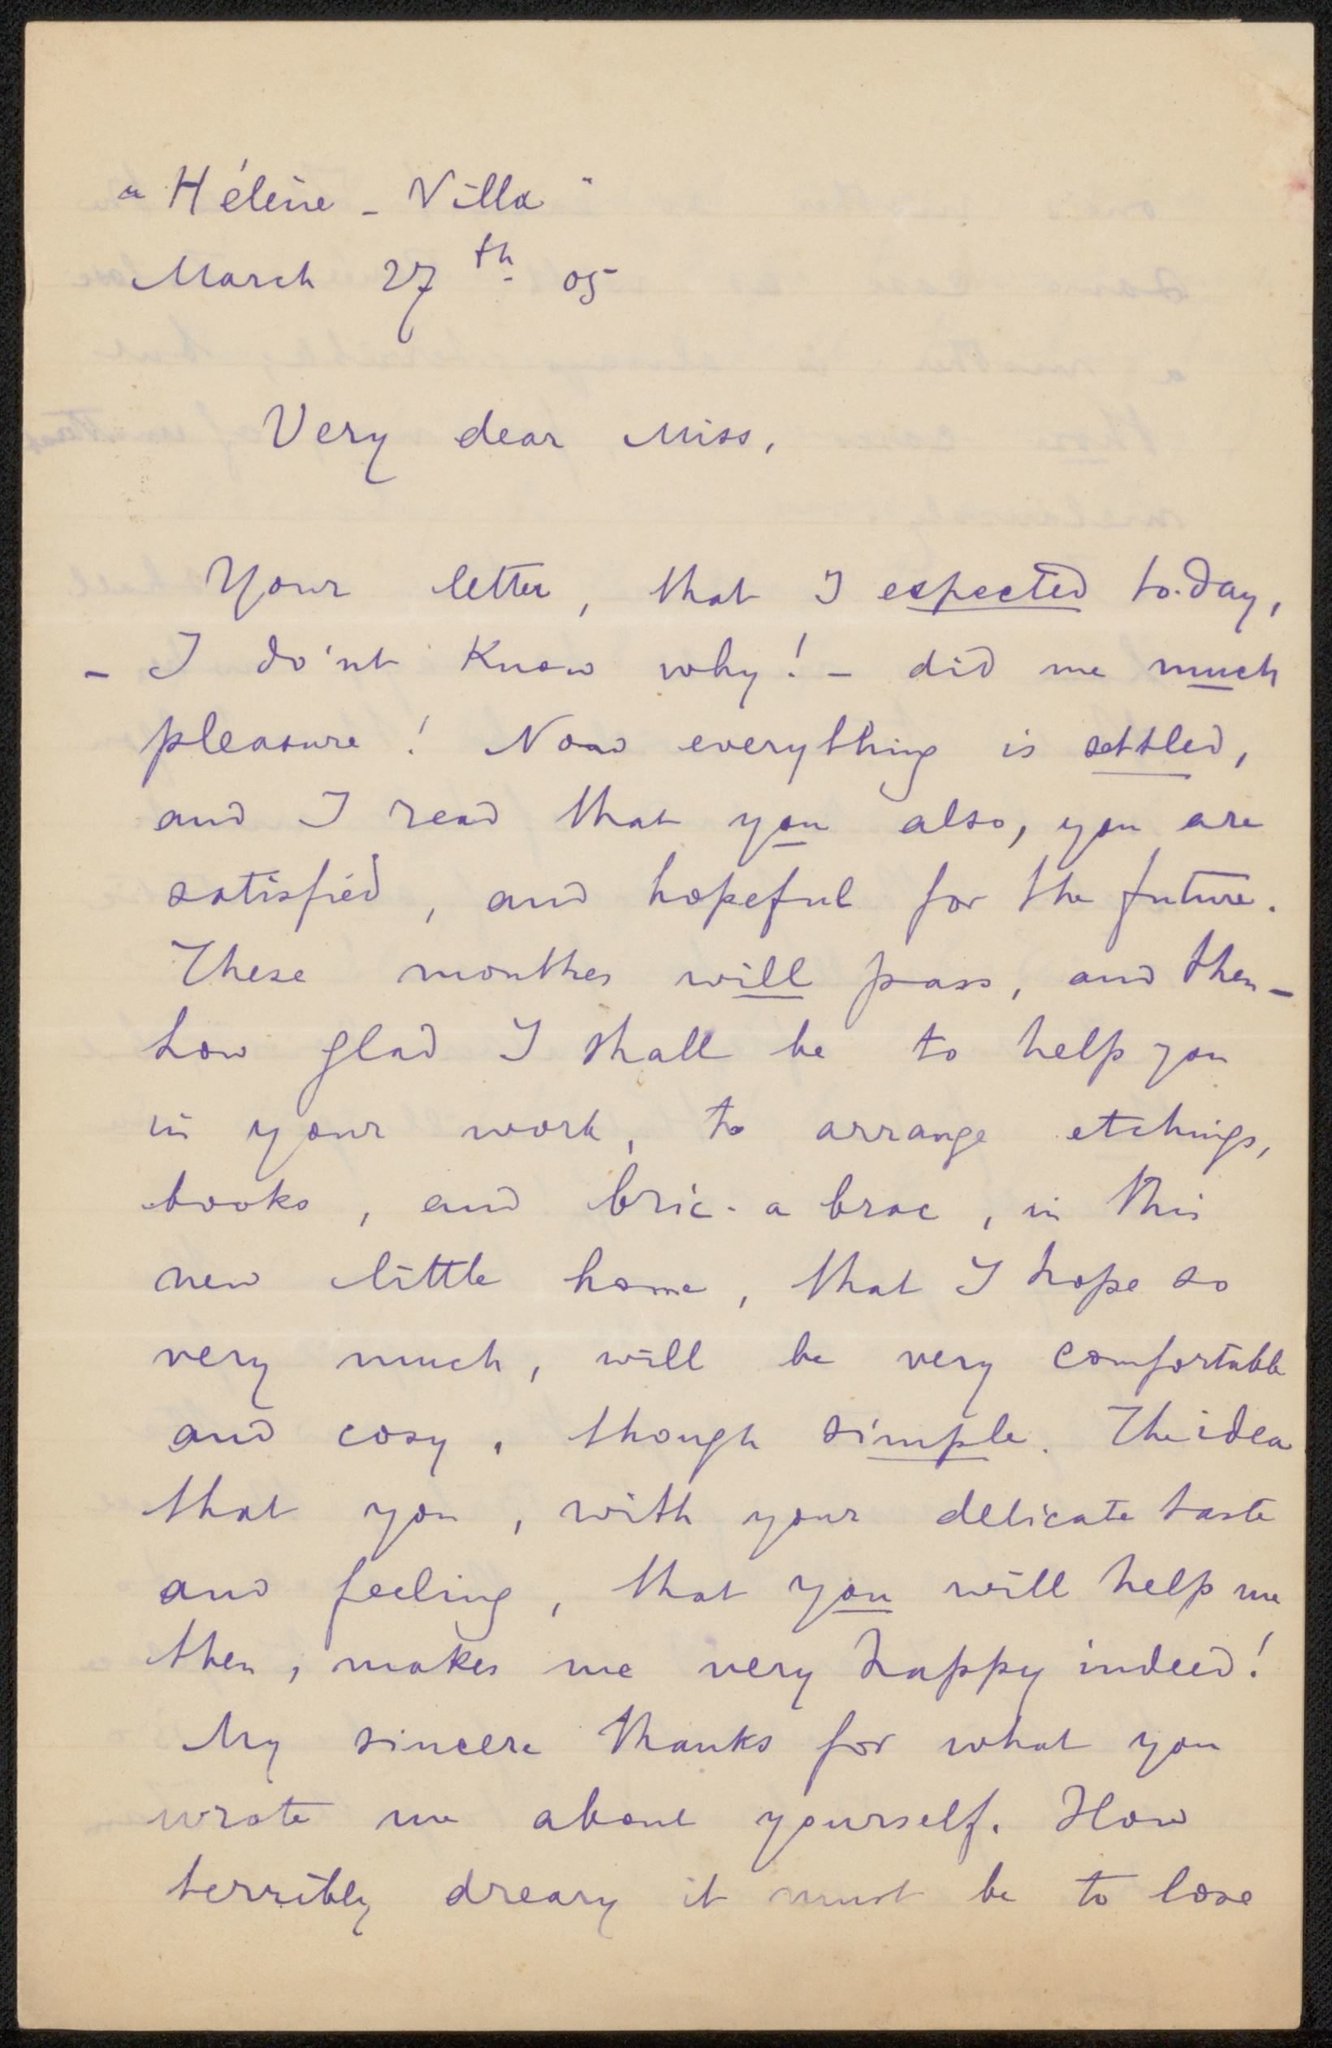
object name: letter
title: Brief aan Elsie Maud Cownie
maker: philip zilcken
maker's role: draughtsman, painter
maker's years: 1857-1930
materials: ink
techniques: pen, writing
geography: the hague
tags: lyon, alphonse stengelin, voorburg, print maker, renée hélène laure zilcken, manchester, the hague, draughtsman, elsie maud cownie, art trade, art shop, passions, emotions, affections, the graphic arts, family life, travelling; tourism, education, tuition of the artist (in general), painting (including book-illumination, miniature-painting), exhibition ~ art, money, brussels, paris, venice